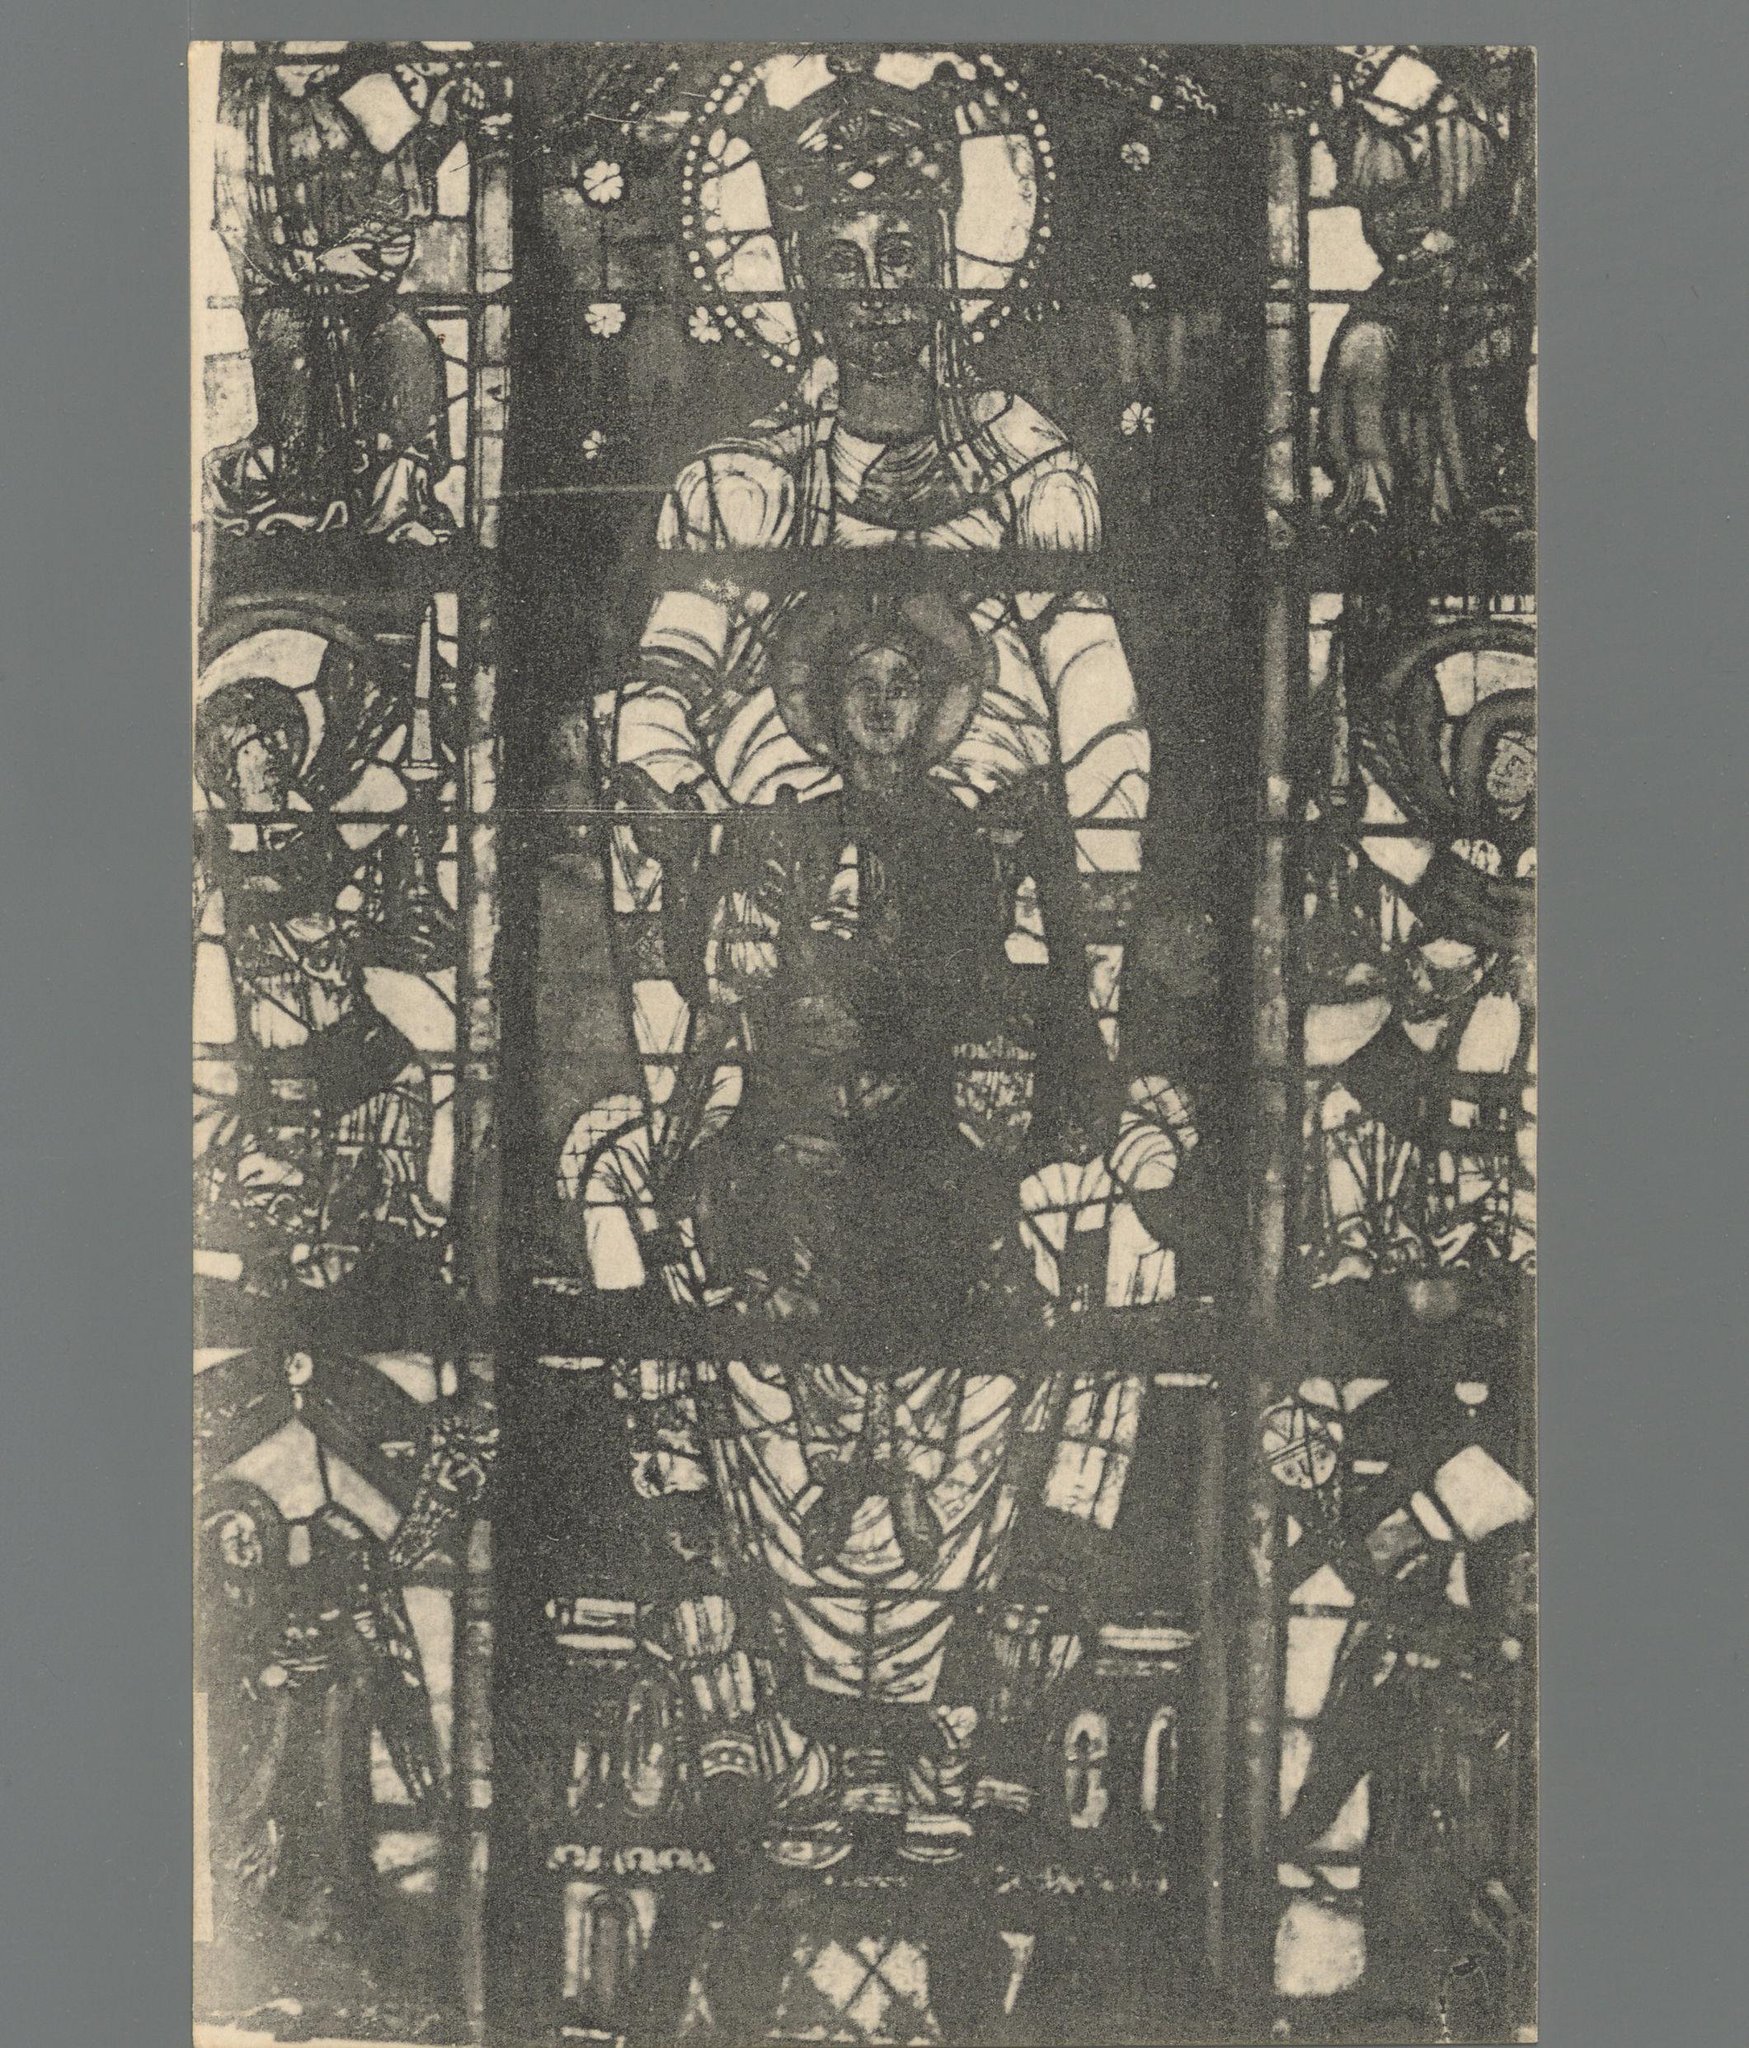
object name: photomechanical print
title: Cathédrale de Chartres (E. et-L). Notre Dame de la Belle Verrière (XIIe siècle)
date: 1903-1930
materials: cardboard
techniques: photograph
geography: chartres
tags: church-window, e.g. rose-window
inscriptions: collector's mark: ‘AFE v S’